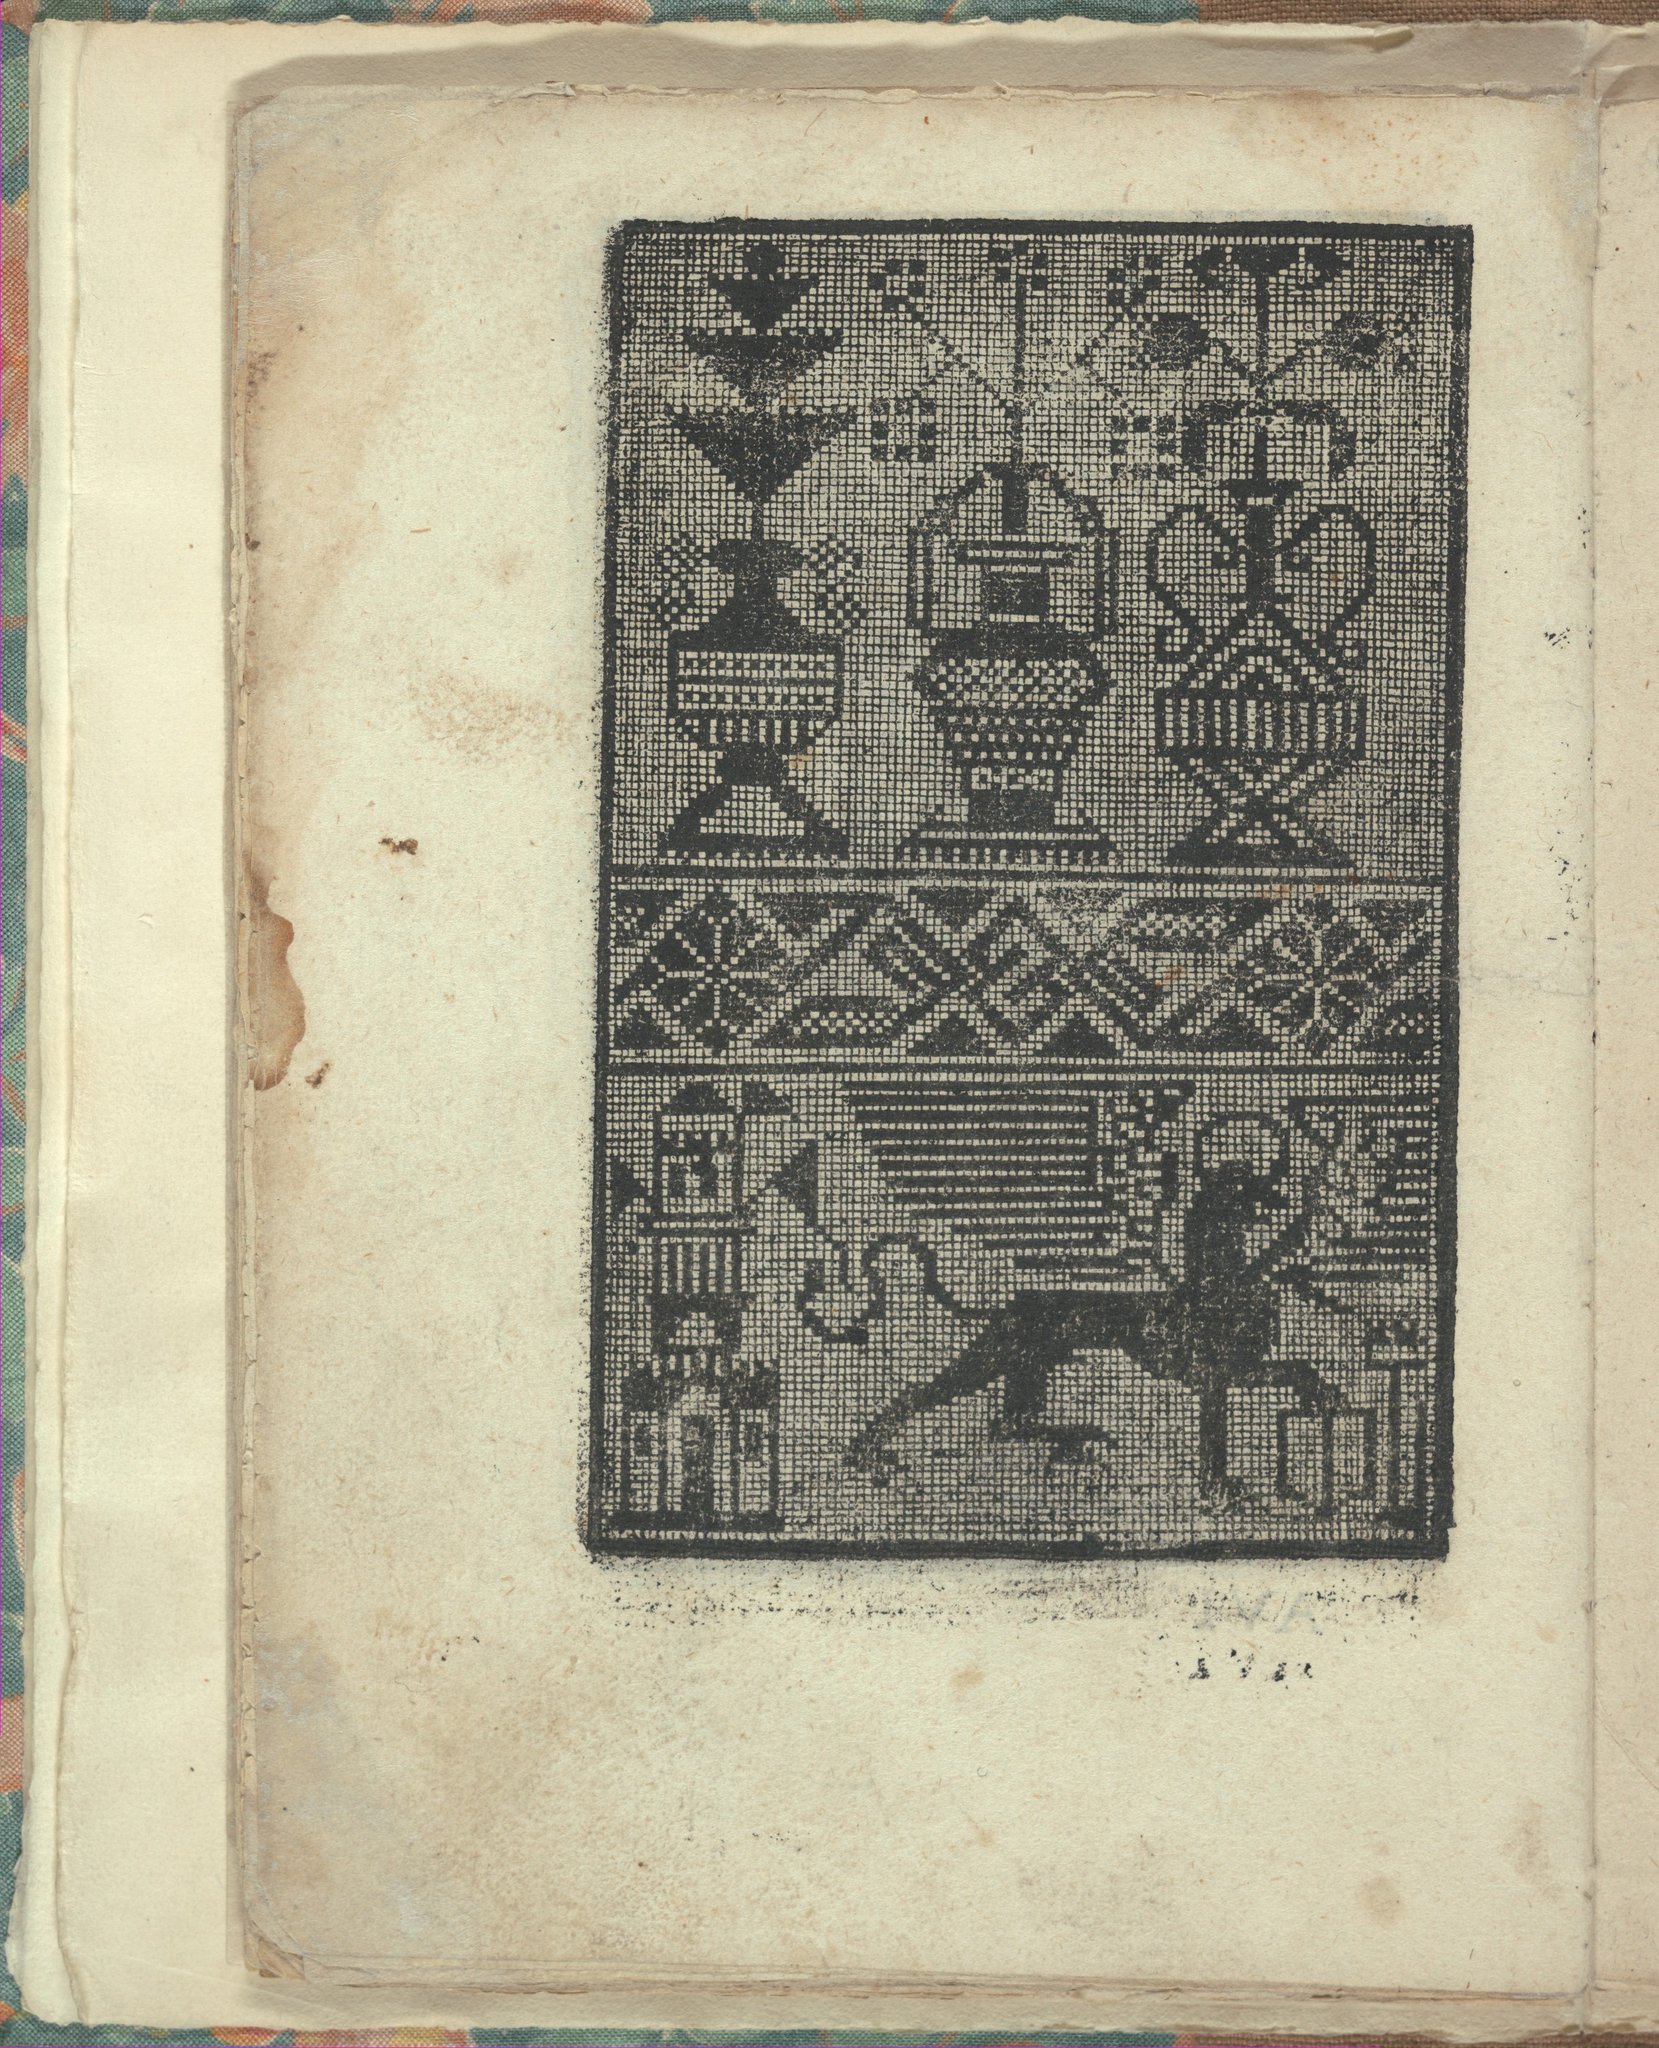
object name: book print ornament architecture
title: Opera Nova Universali intitulata Corona di racammi, page 26 (verso)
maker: giovanni andrea vavassore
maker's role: publisher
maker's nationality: italian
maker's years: 1530-1573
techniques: woodcut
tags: griffins,plants,vases